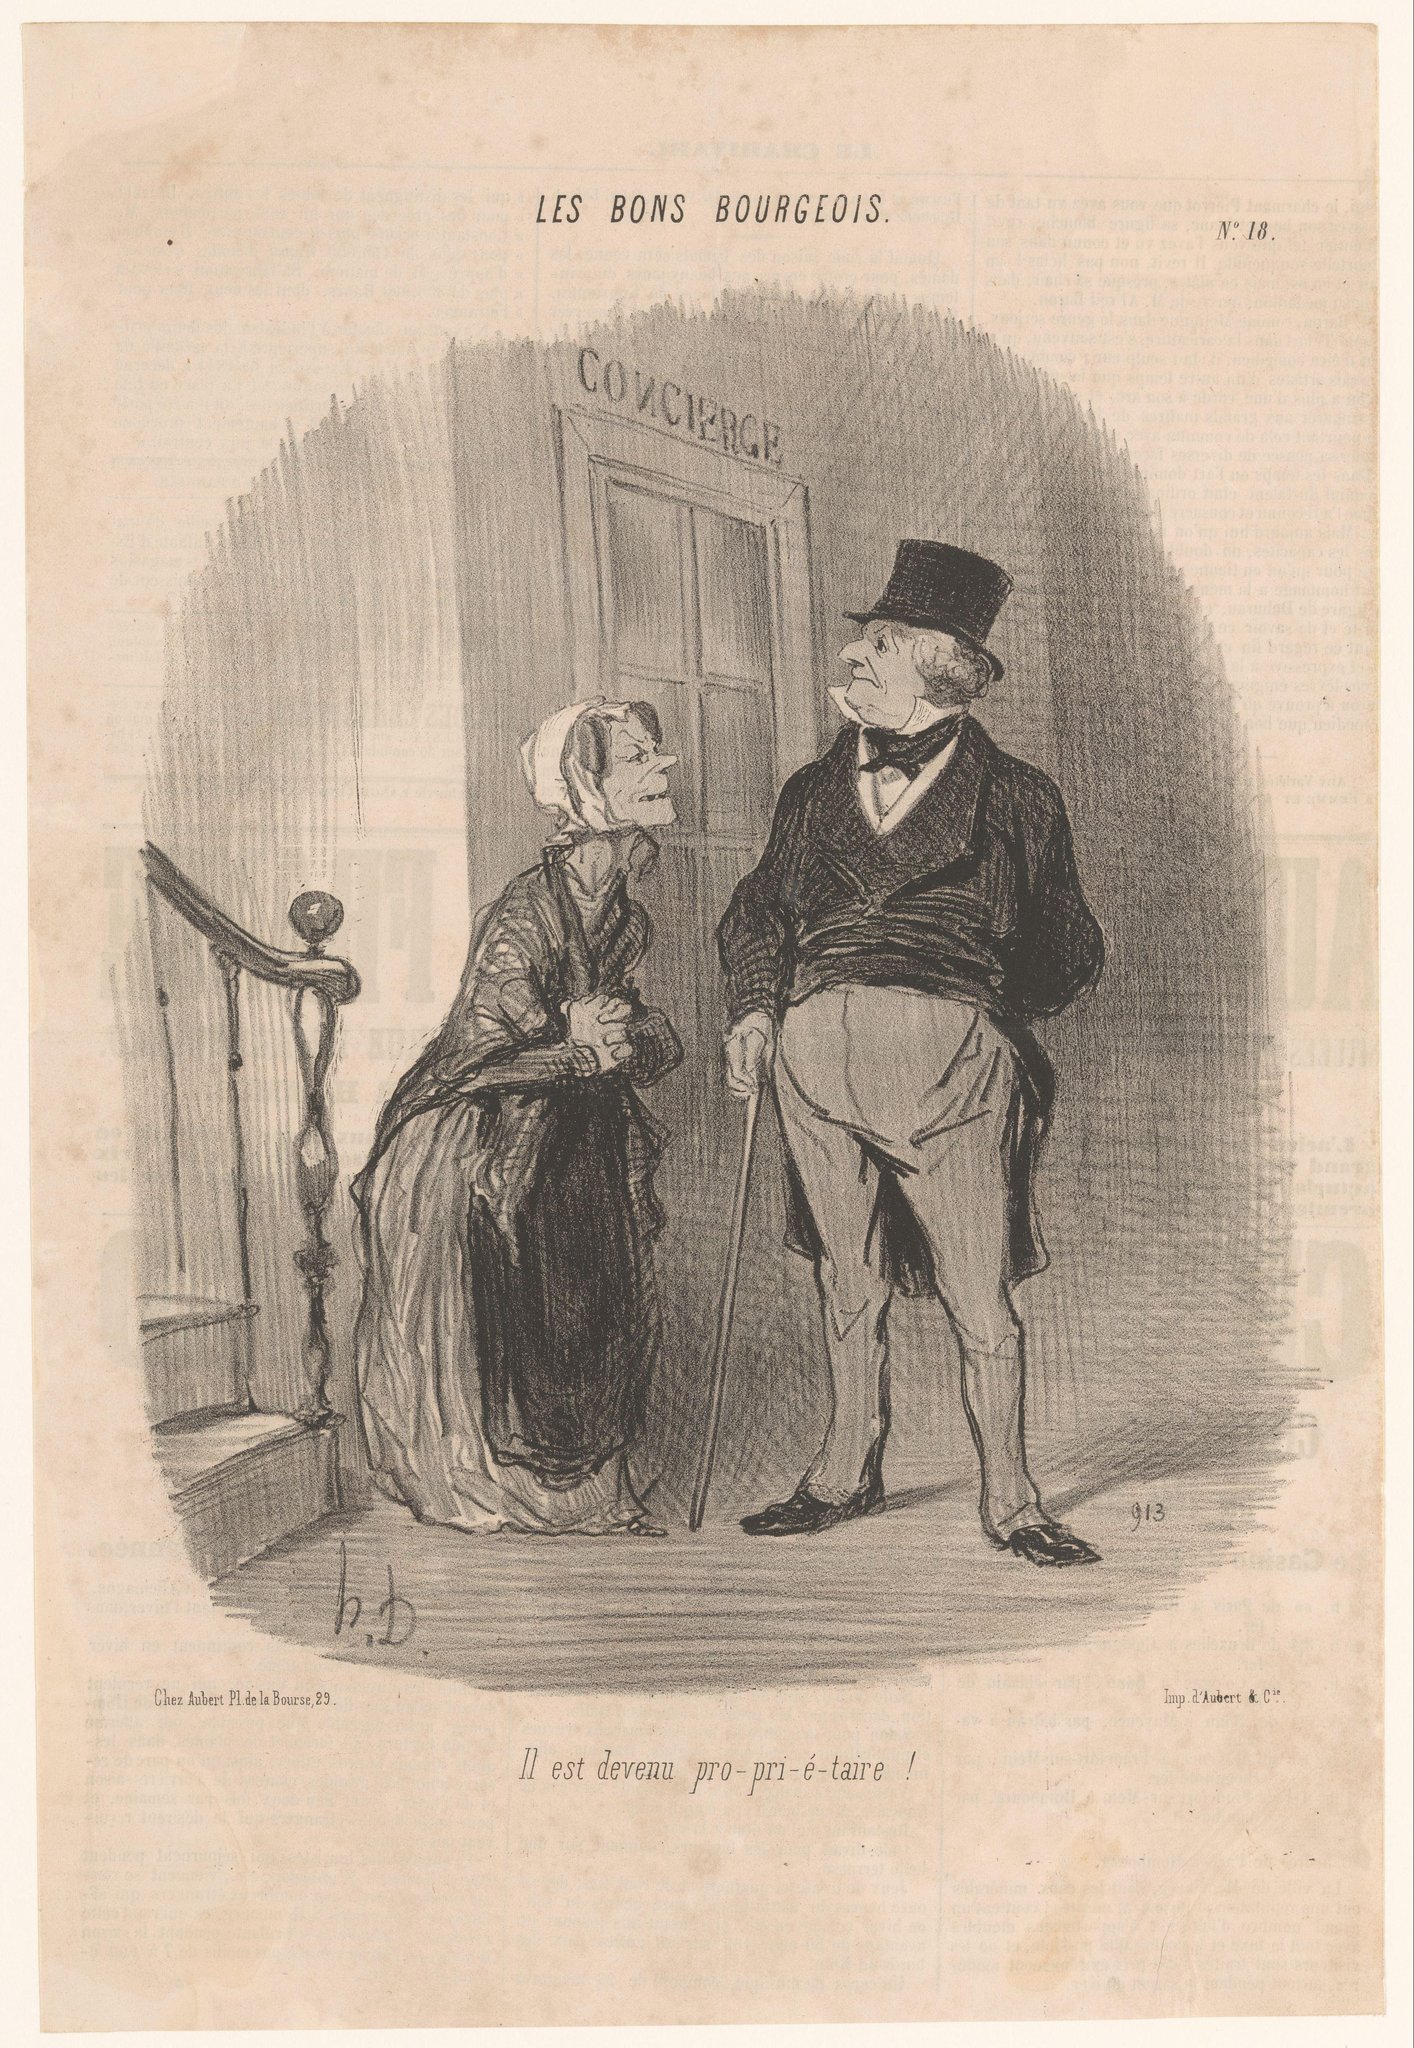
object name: cartoon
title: Il est devenu pro-pri-é-taire!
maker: honoré daumier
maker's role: draughtsman, painter, print maker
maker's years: 1808-1879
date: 1846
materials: paper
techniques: lithograph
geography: paris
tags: caricatures (human types), old woman, staircase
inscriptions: collector's mark: Lugt 2228a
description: Prent gebruikt voor: Le Charivari, 06-10-1846.